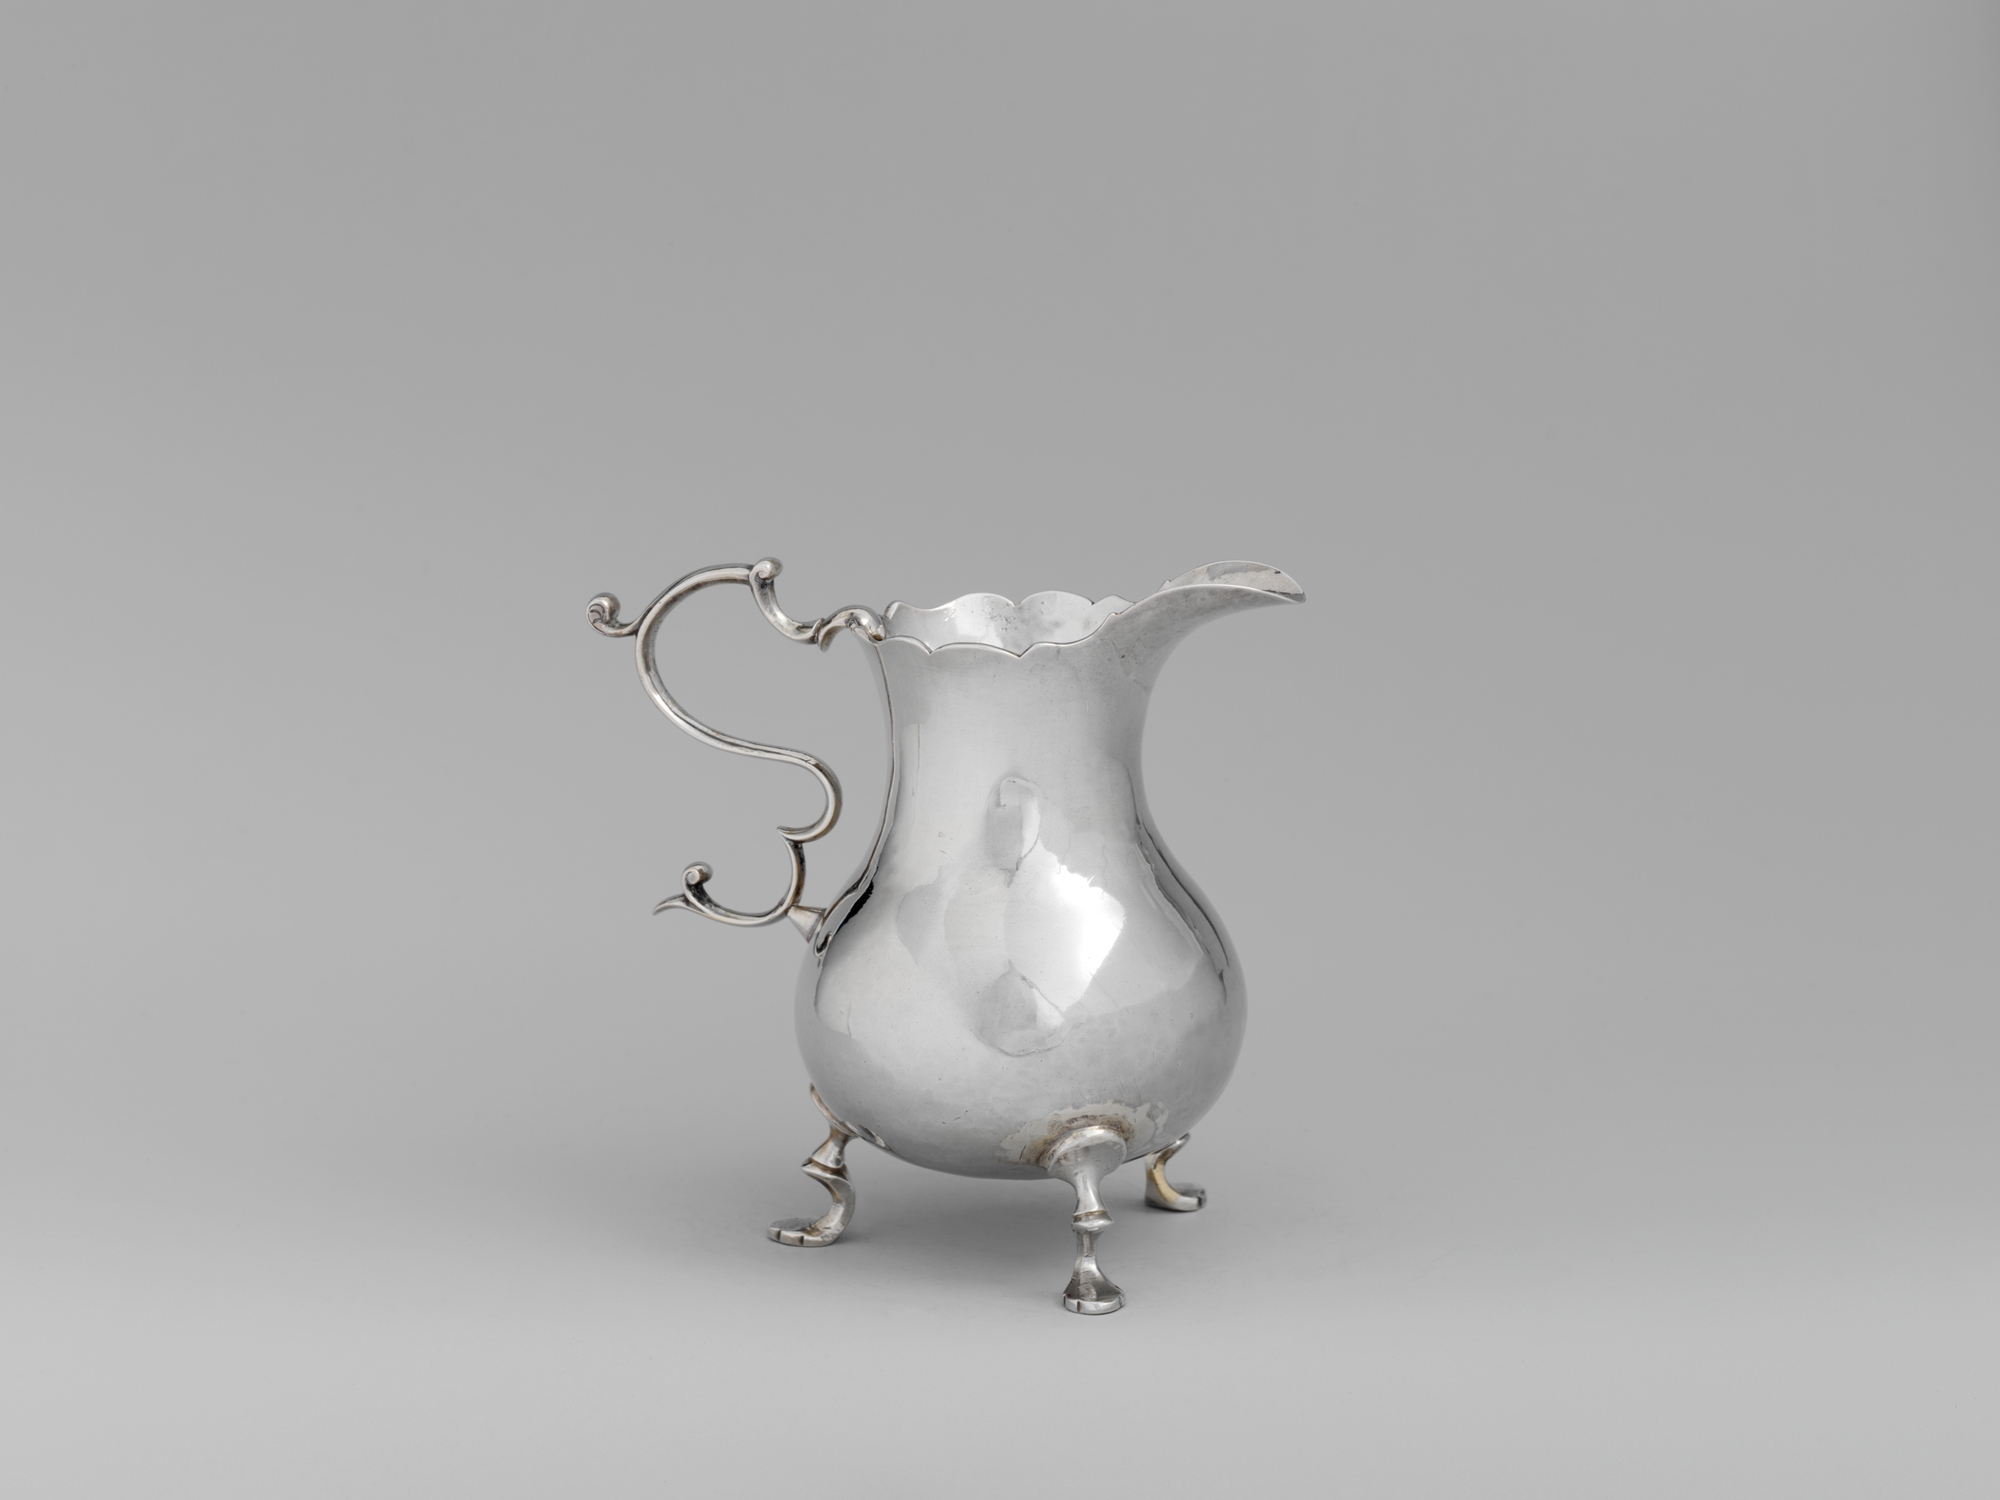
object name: cream pot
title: Creampot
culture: american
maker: samuel casey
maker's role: maker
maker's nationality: american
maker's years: 1718-1780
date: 1750-1770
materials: silver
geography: united states